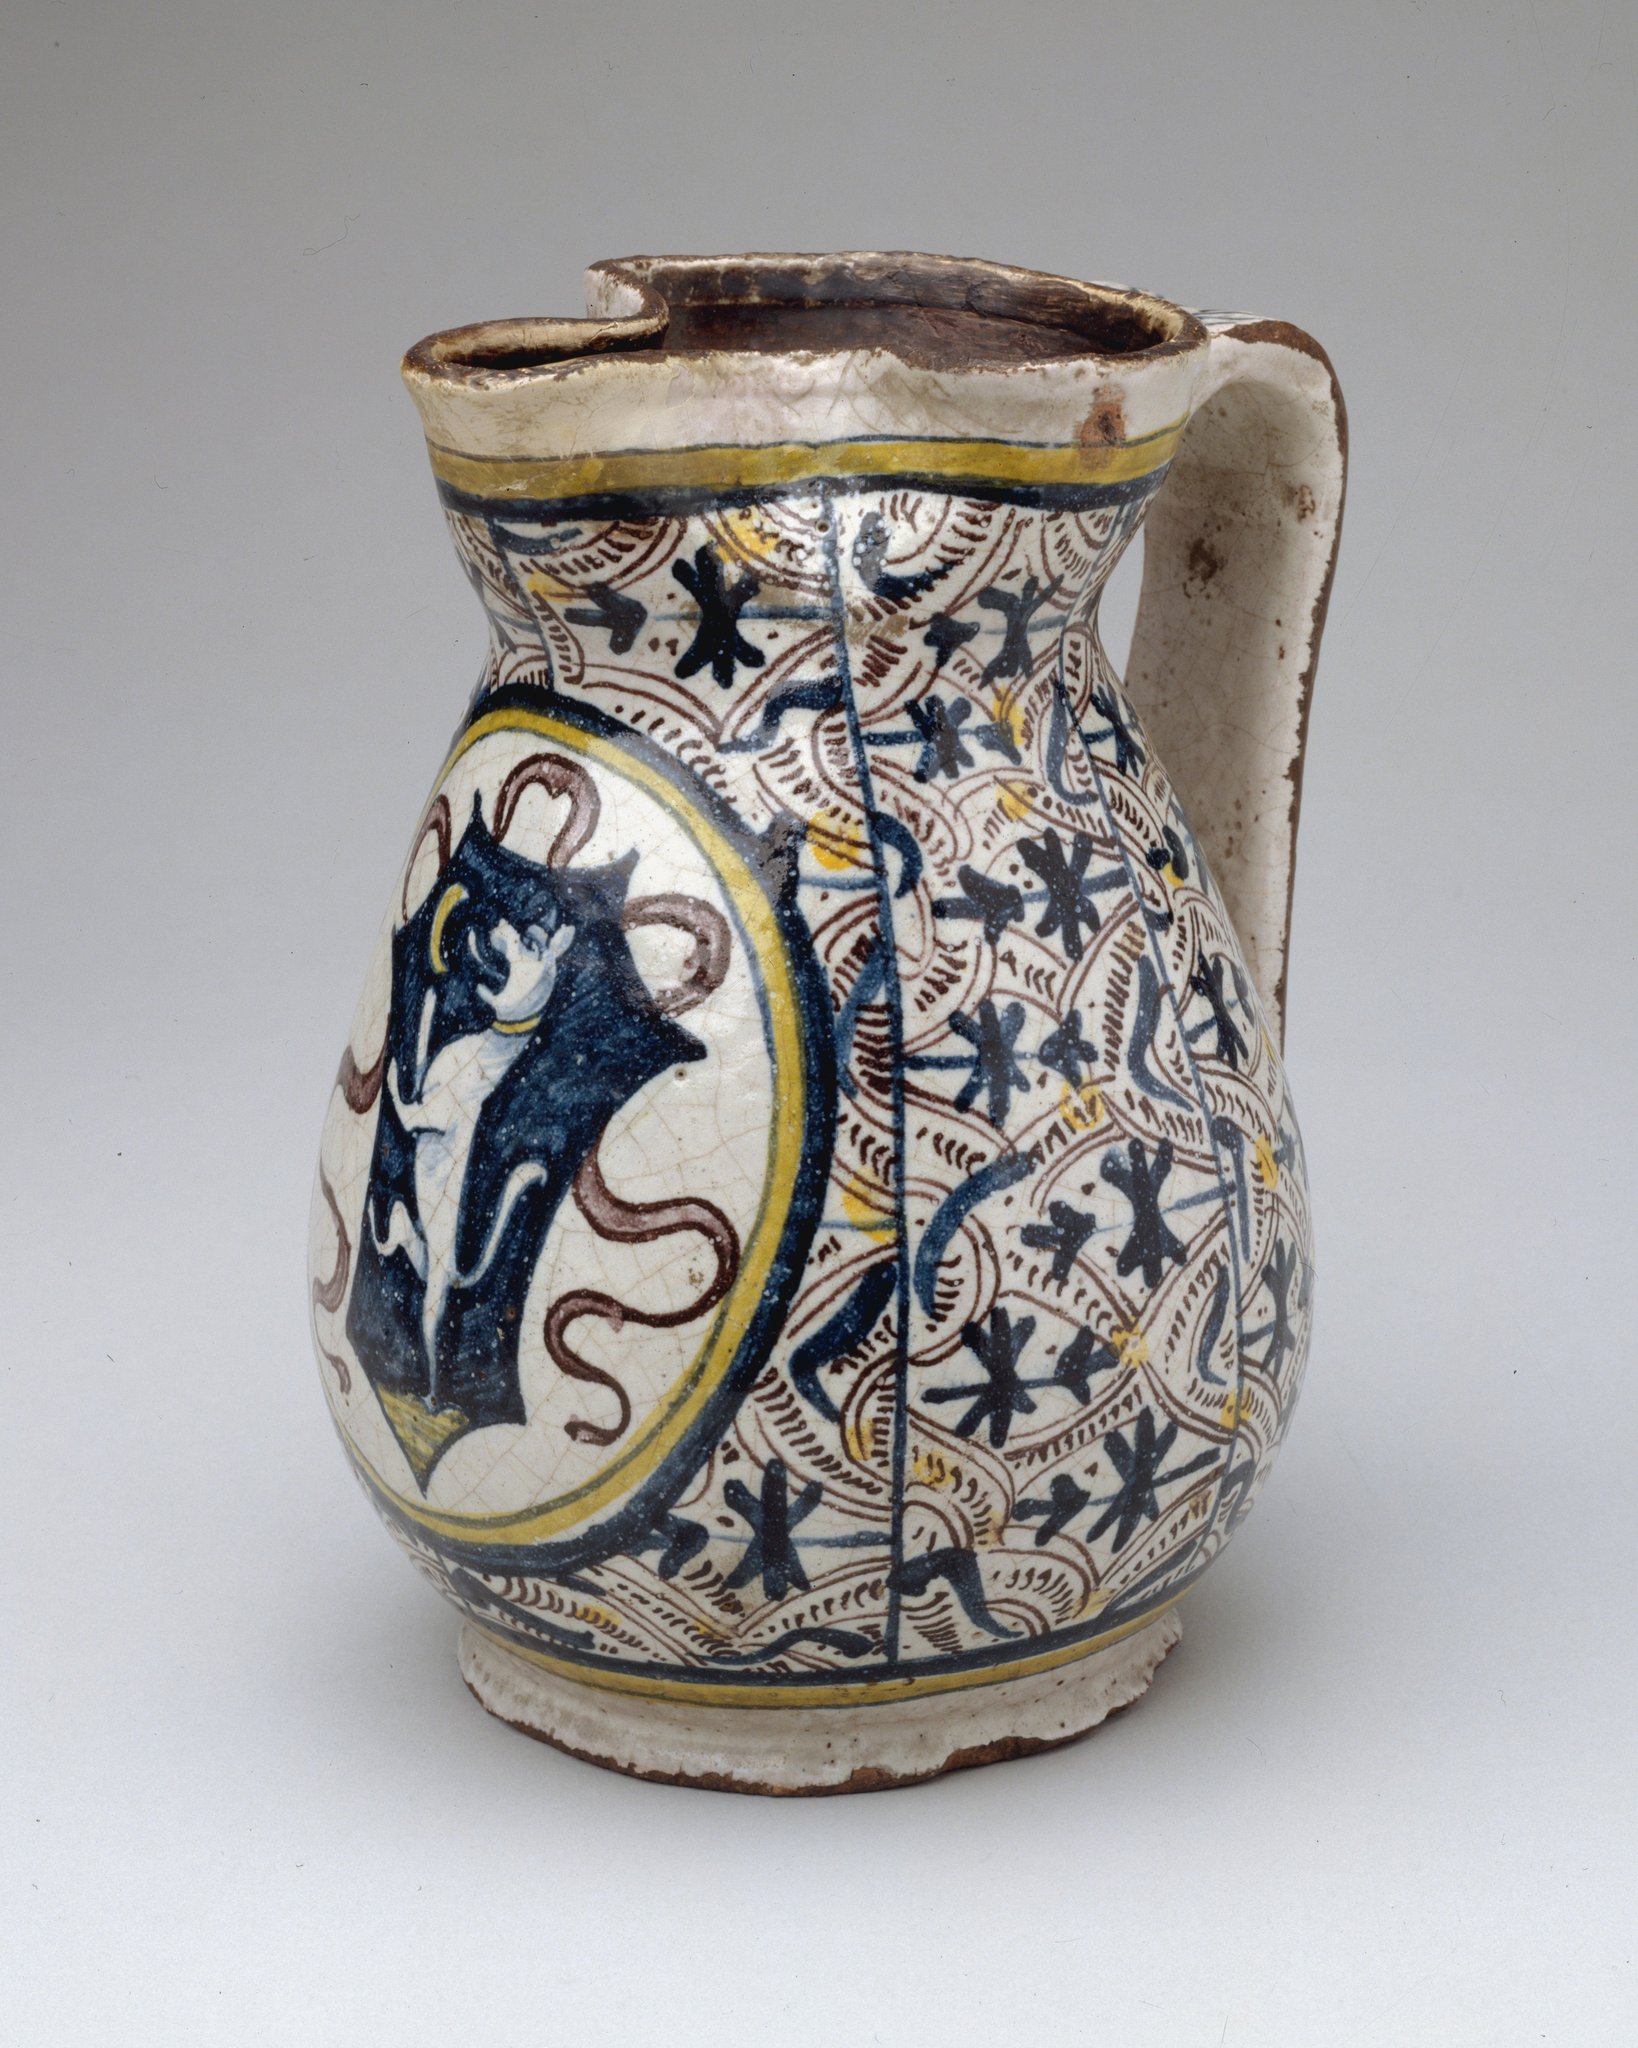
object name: jug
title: Armorial Jug (boccale)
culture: italian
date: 1460-1480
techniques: maiolica, glazing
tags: coat of arms